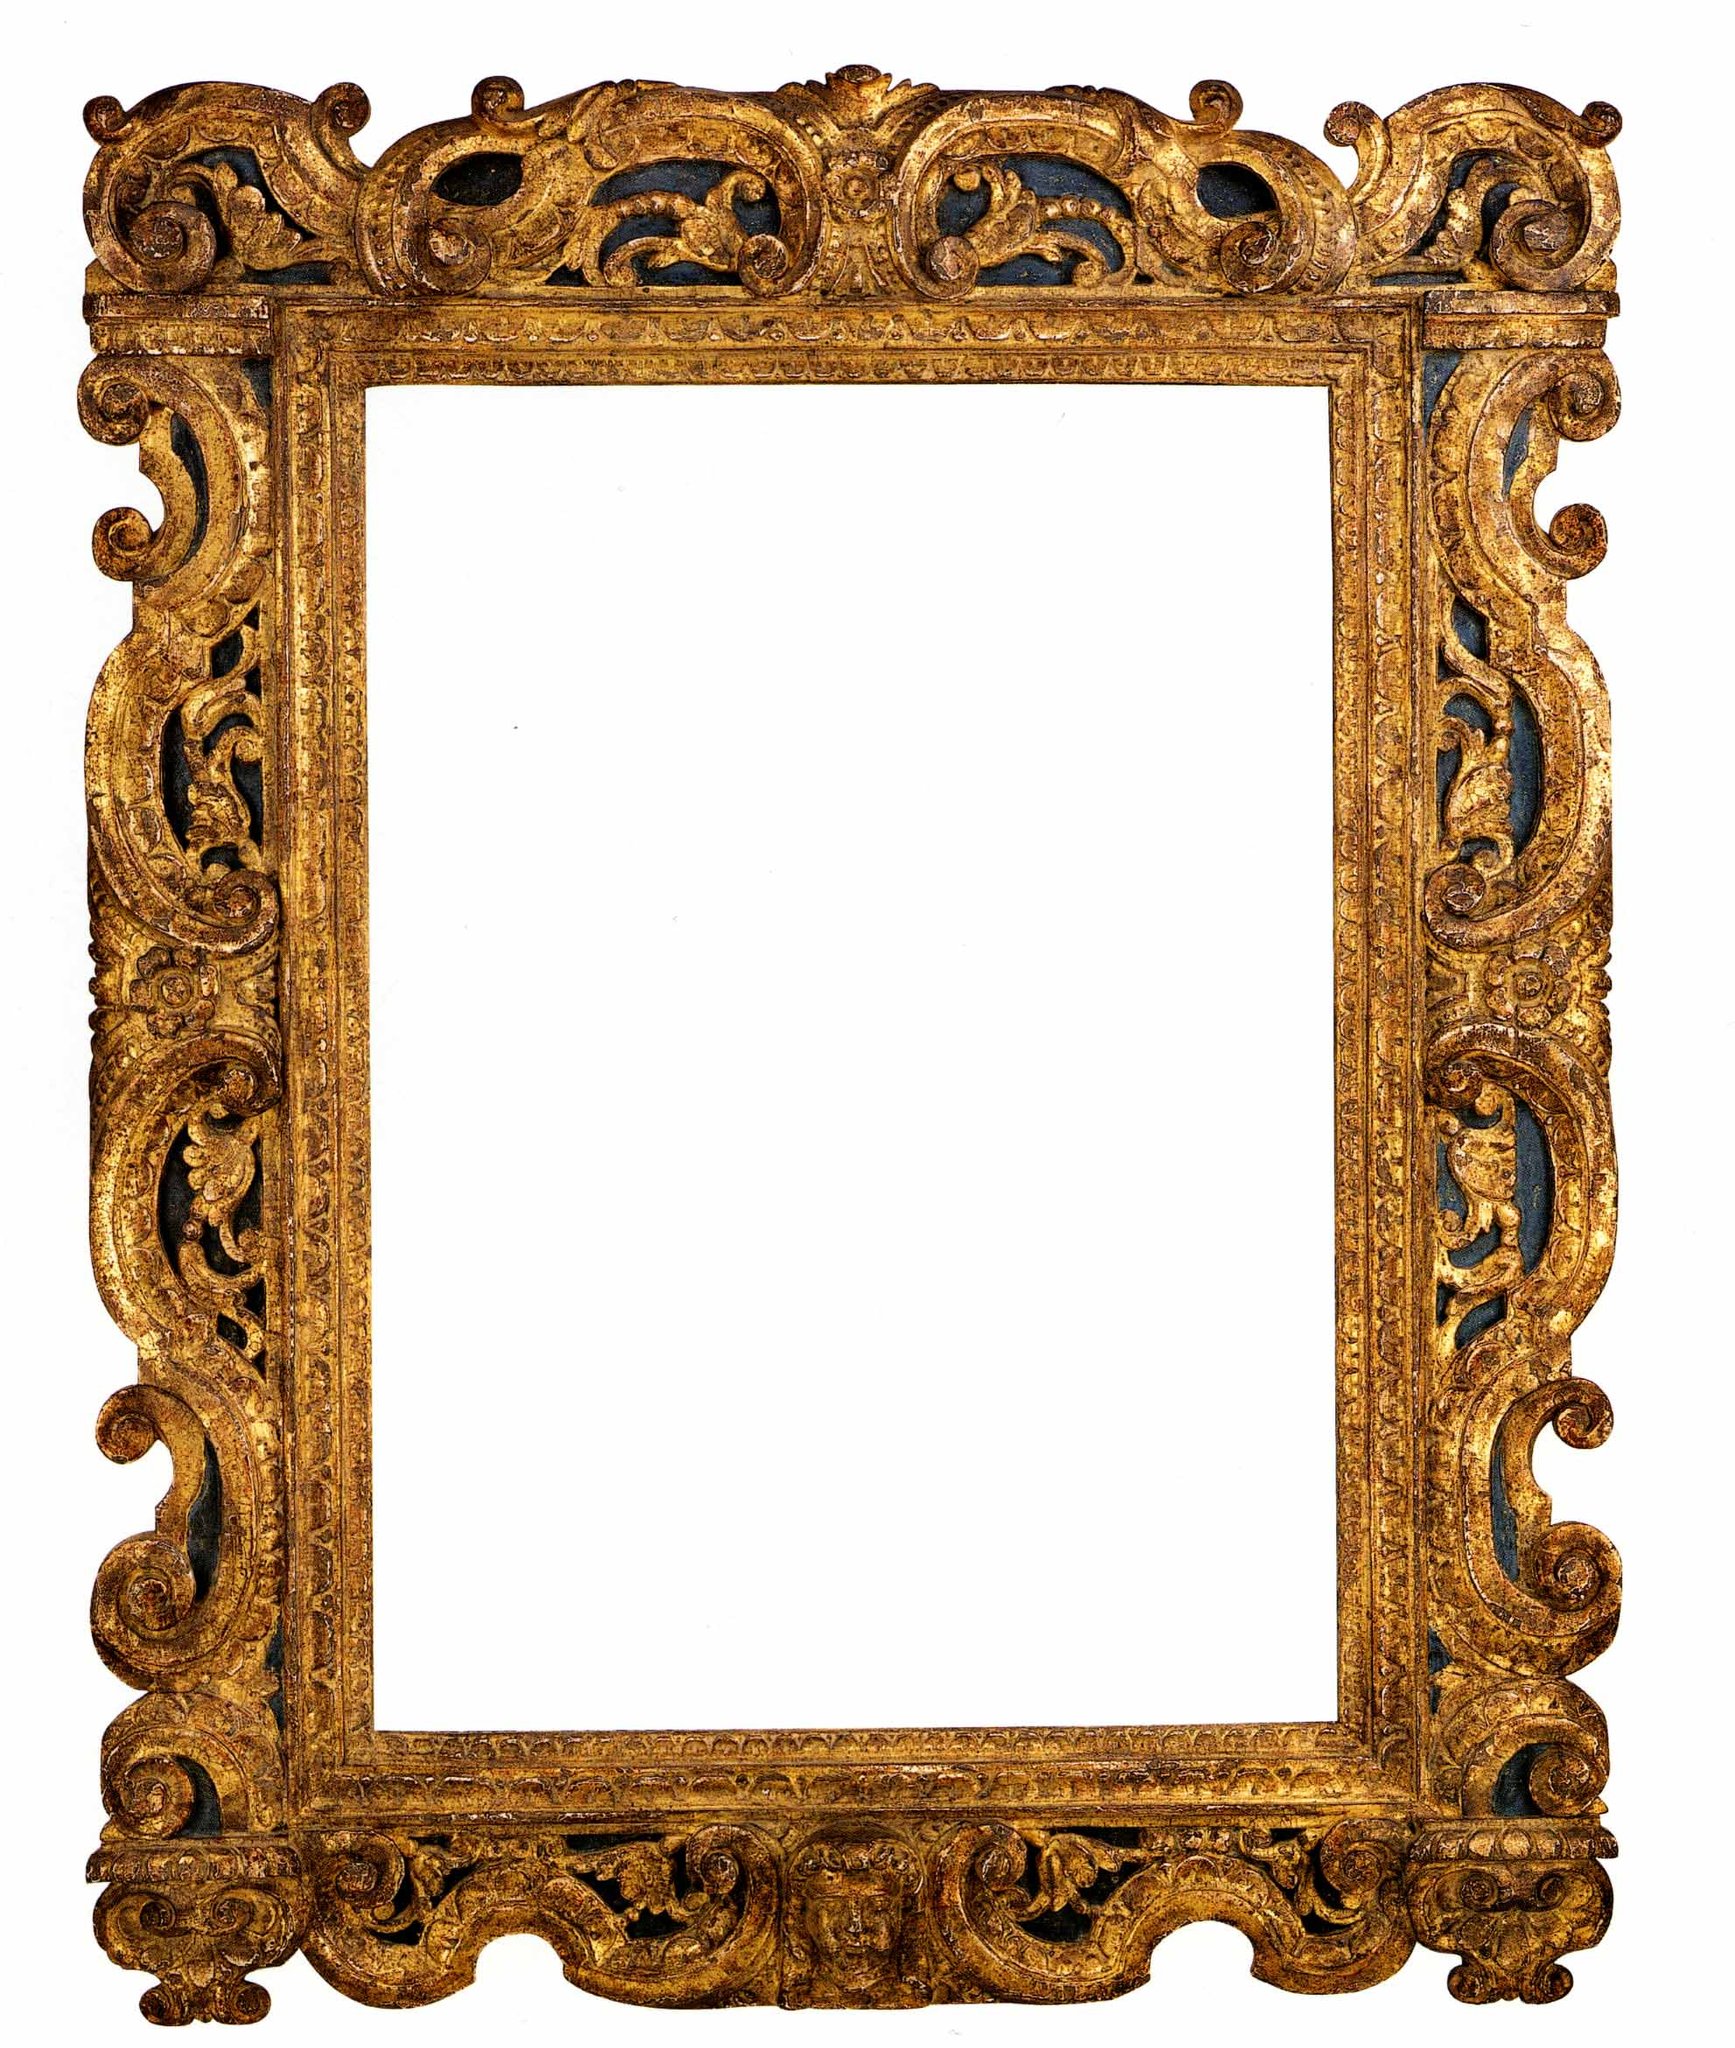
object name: frame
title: Sansovino-style frame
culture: venetian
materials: gilt, wood